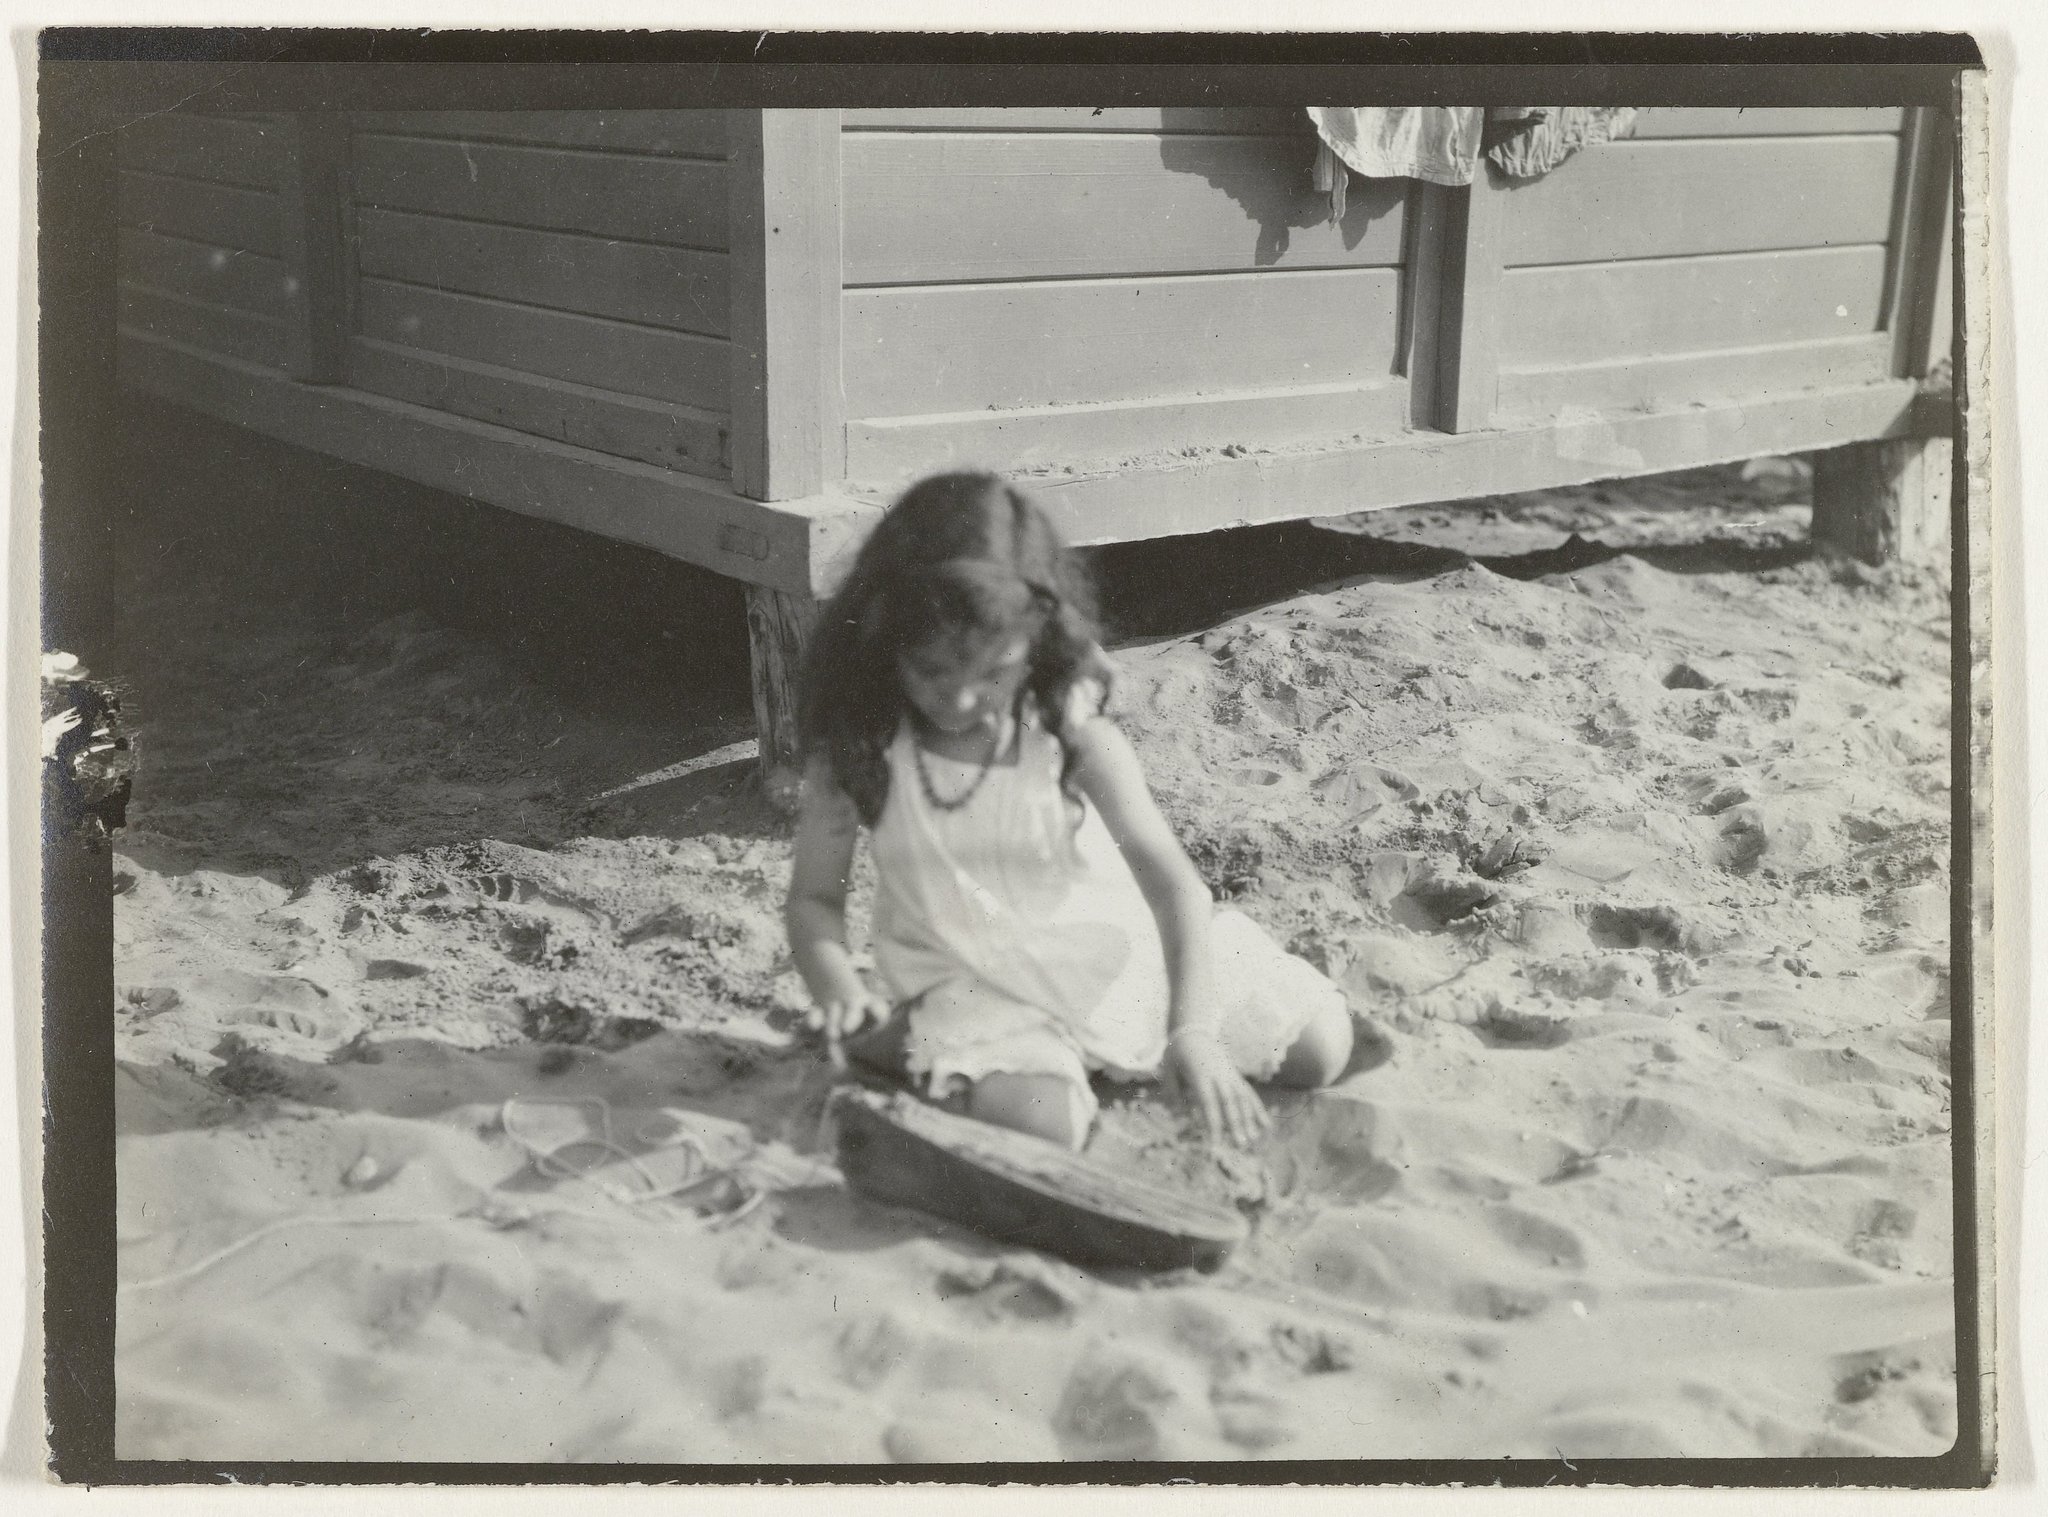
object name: photograph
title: Meisje spelend op het strand (Noordzeekust), Nederland of Duitsland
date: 1900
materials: paper, photographic support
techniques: gelatin silver print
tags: beach (as place of recreation), netherlands, germany